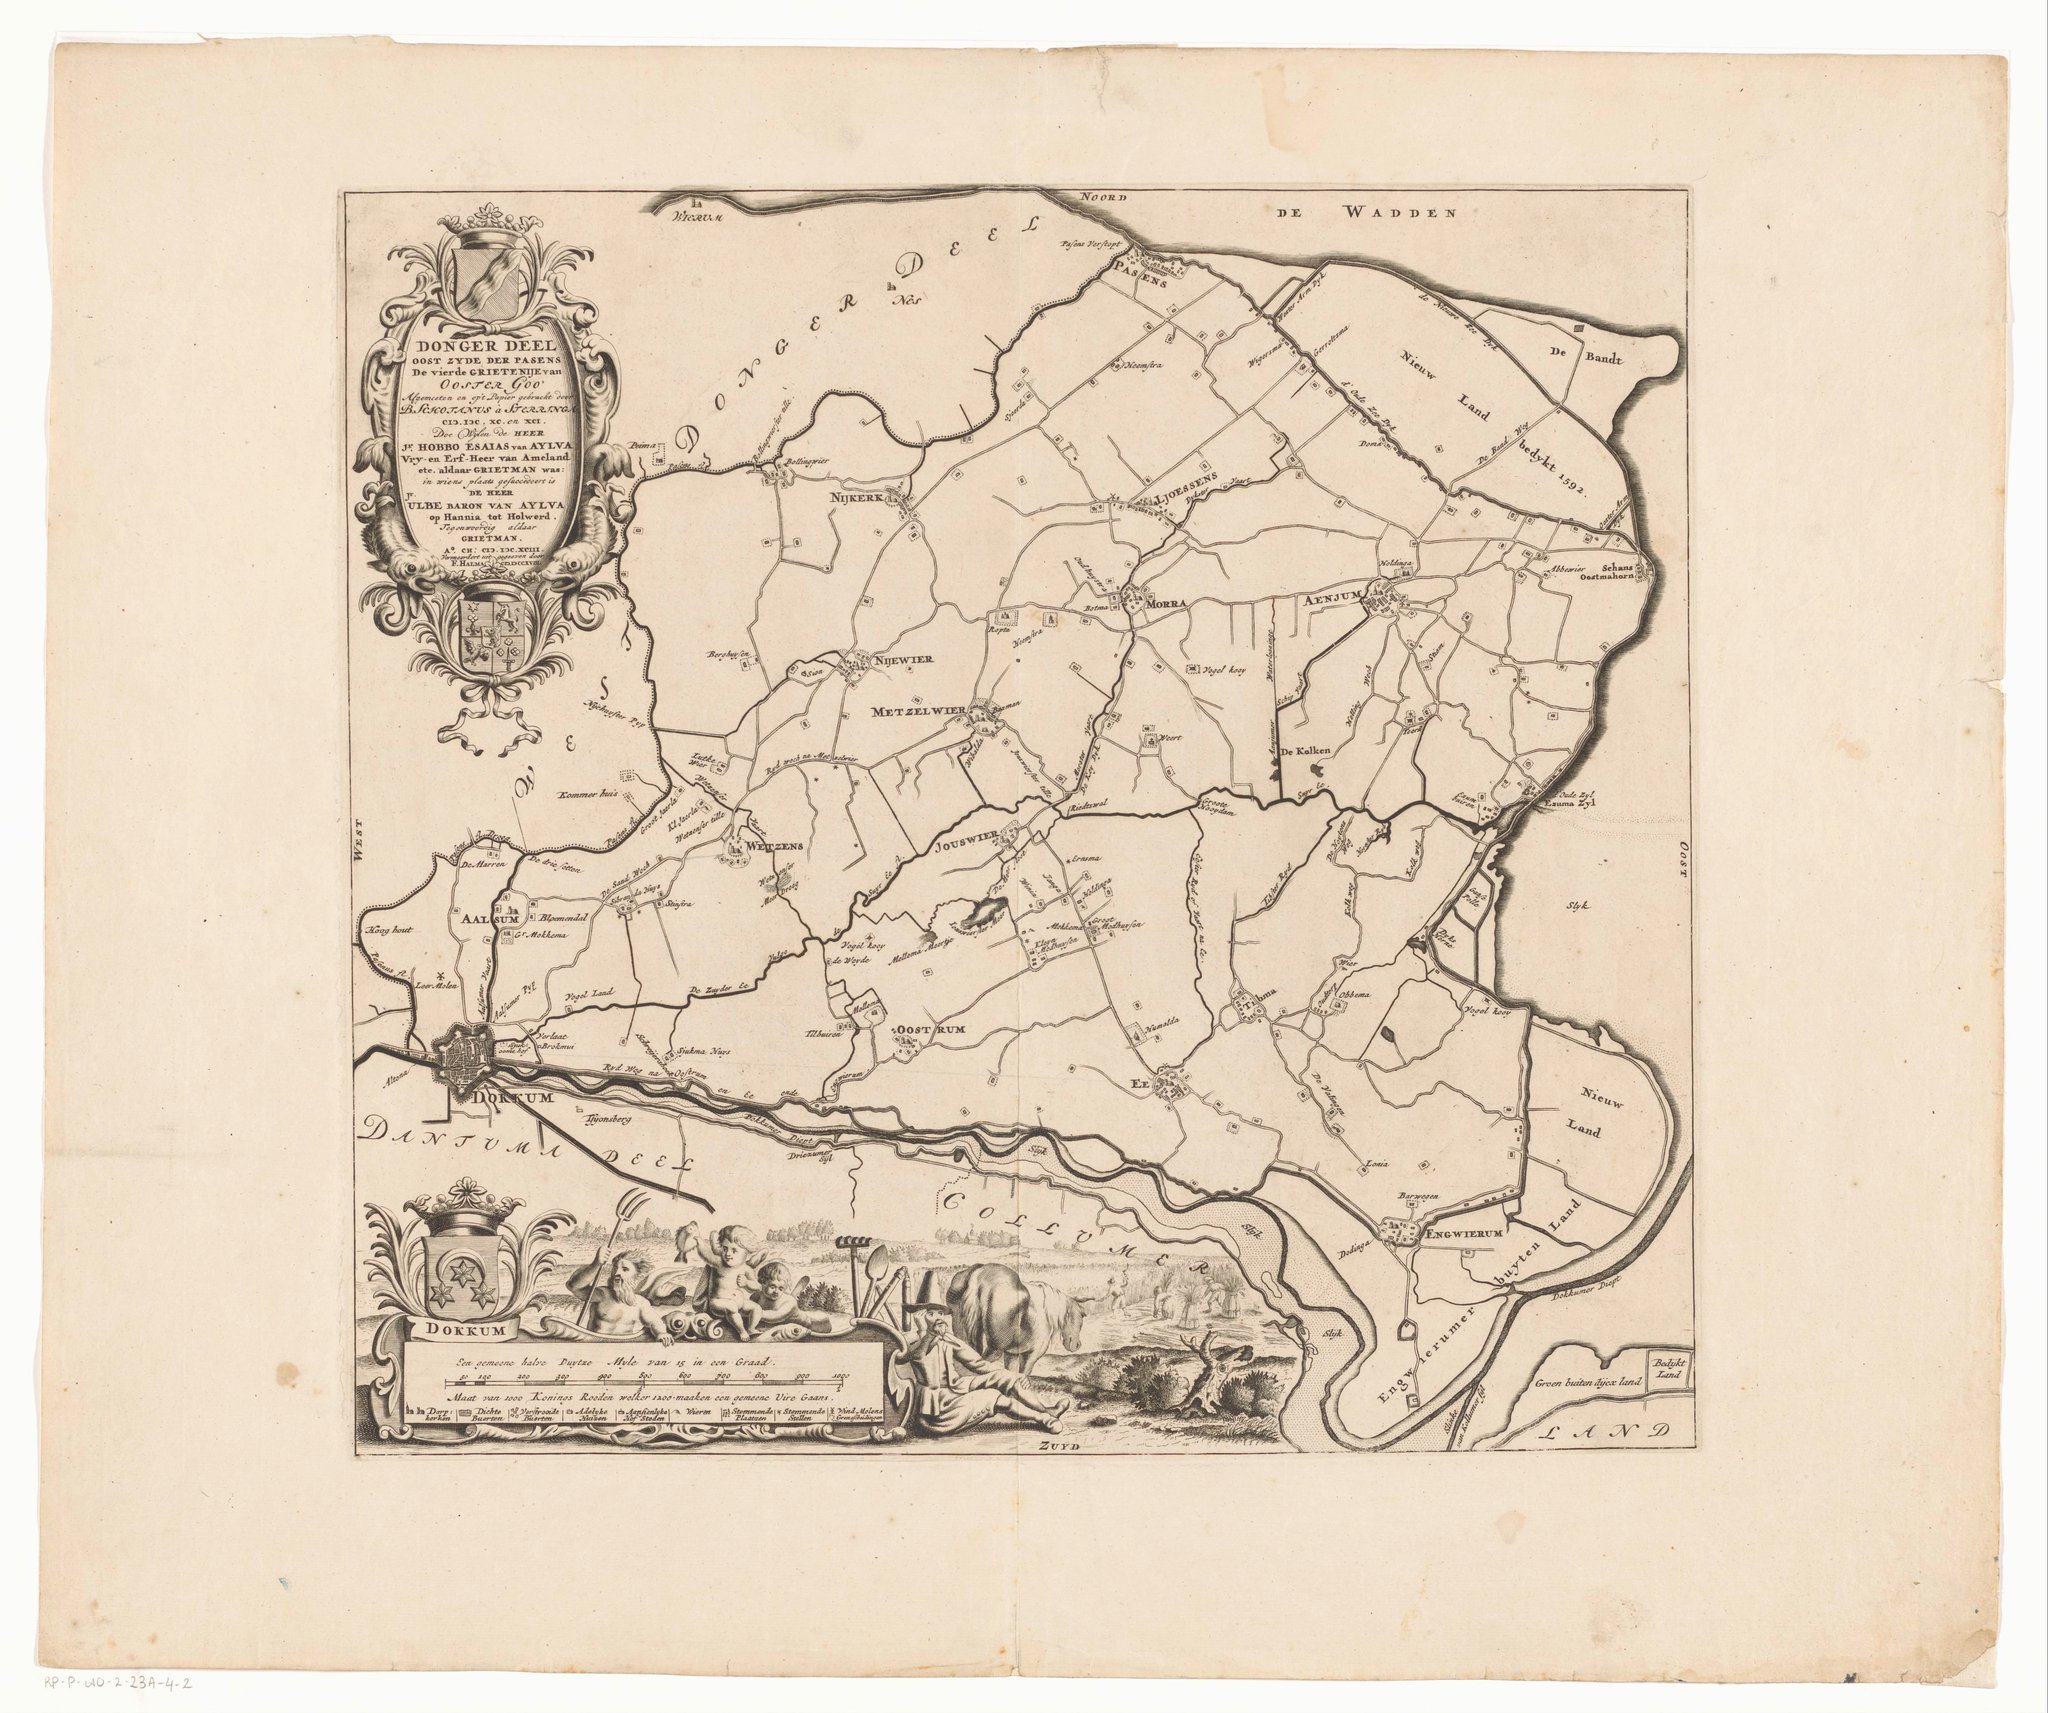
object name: print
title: Donger deel oost zyde der Pasens de vierde grietenije van Ooster goo (...)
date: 1698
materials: paper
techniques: engraving, etching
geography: amsterdam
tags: (story of) neptune (poseidon), coat of arms (as symbol of the state, etc.), maps of separate countries or regions, farmers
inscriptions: collector's mark: Lugt 19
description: Linksboven cartouche met titel, bestuurlijke informatie over de grietenij en de wapens van Oostdongeradeel en van grietman jonker Ulbe baron van Aylva. Linksonder cartouche met legenda en een schaalstok: Een gemeene halve Duytze myle van 15 in een graad - Maat van 1000 konings roeden welker 1200 maaken een gemeene uire gaans. Daaromheen het wapen van de stad Dokkum, Neptunus, twee putti en een landbouwer.